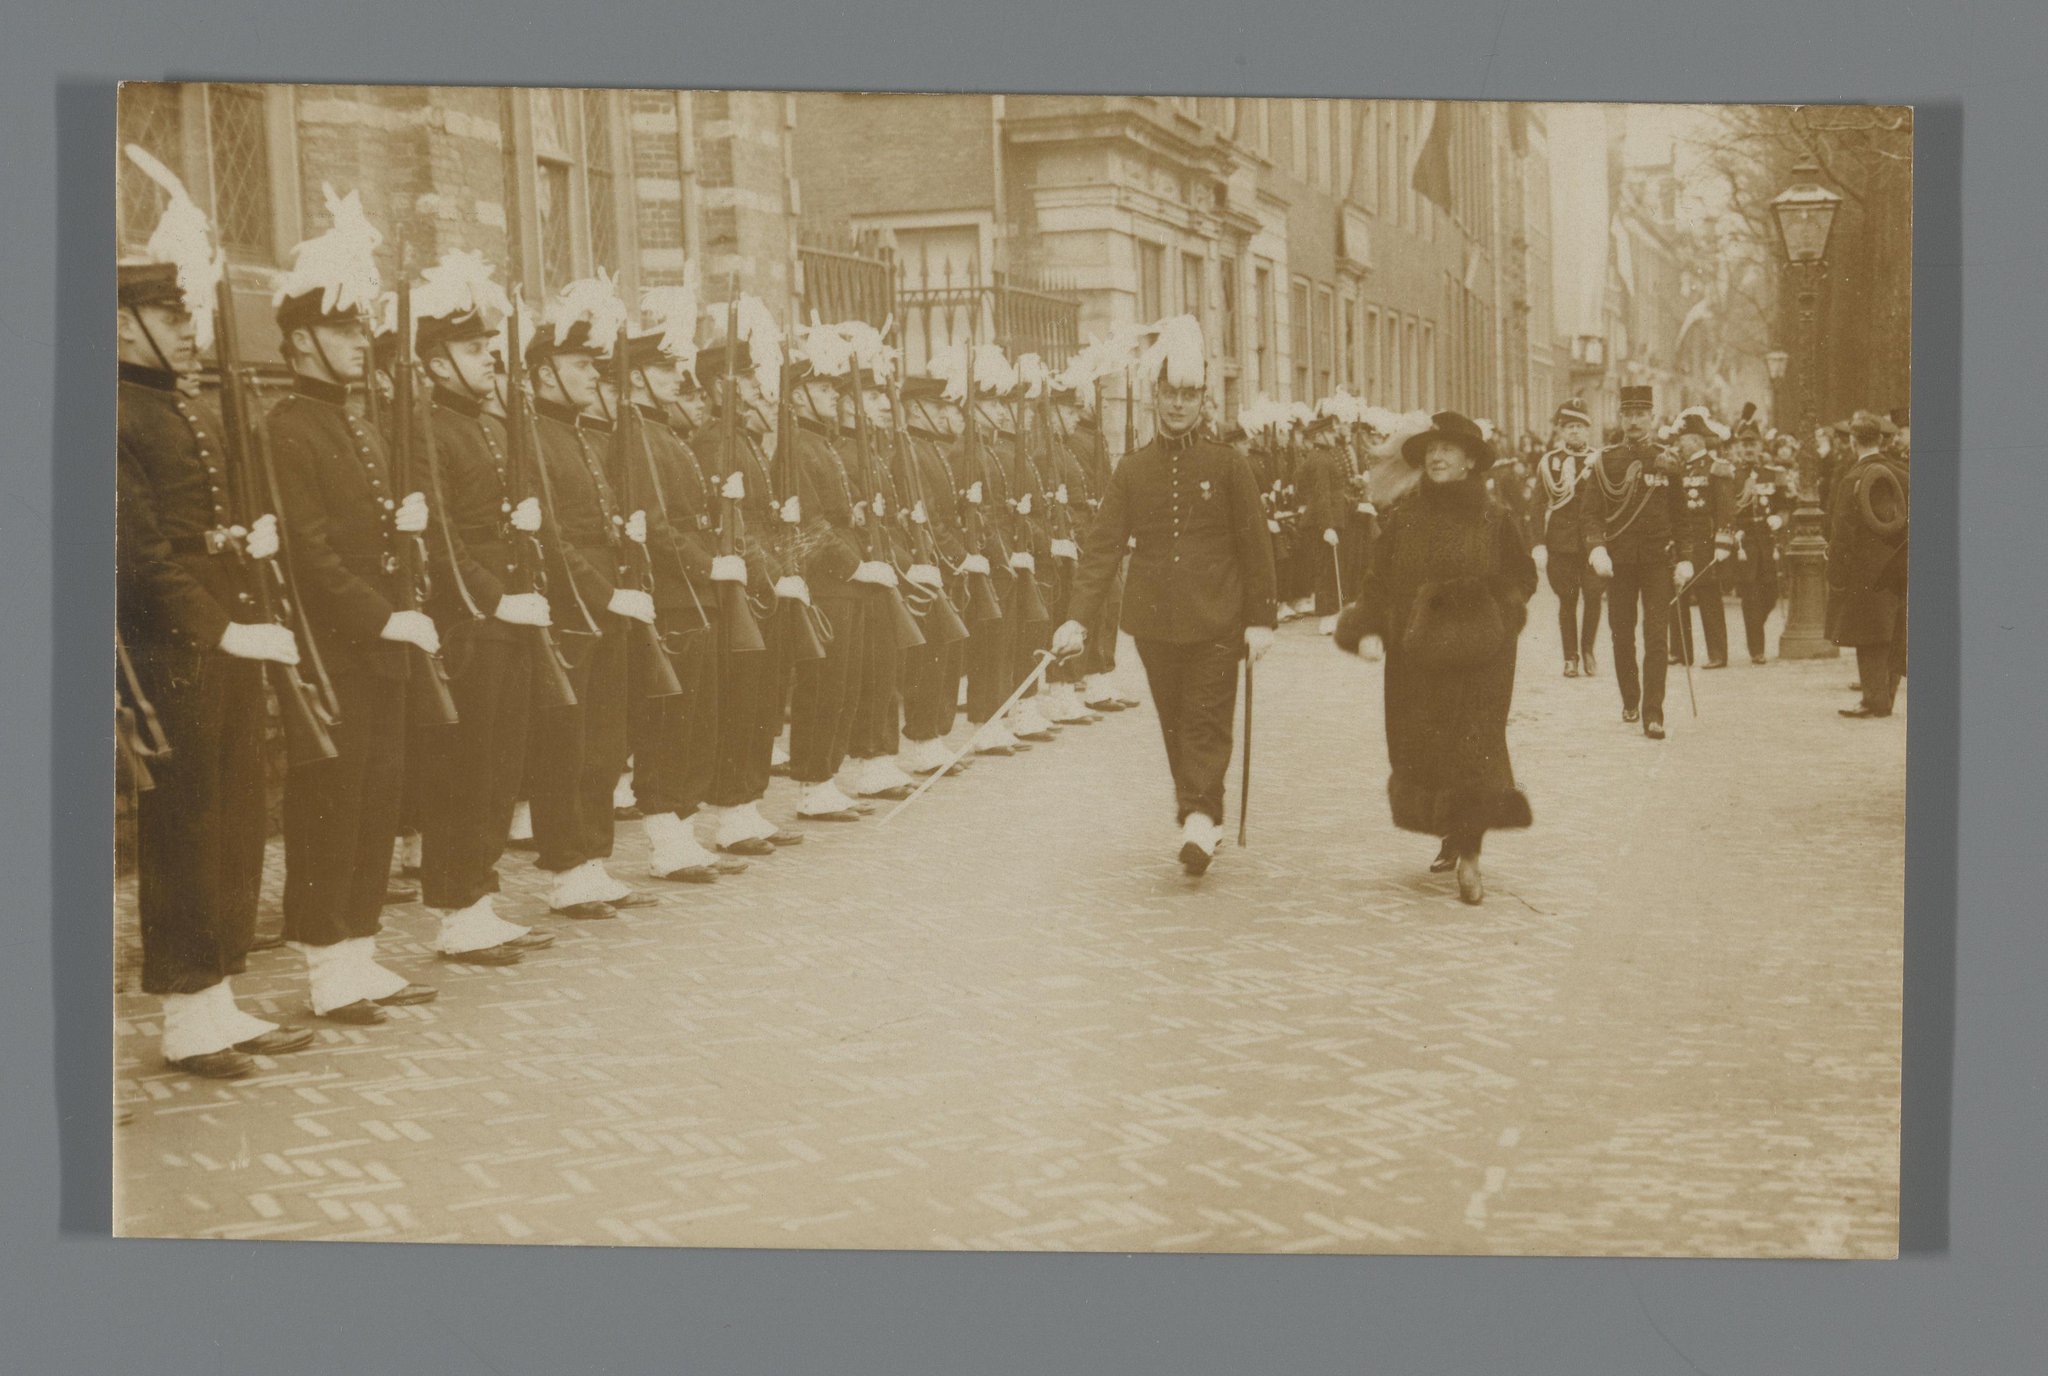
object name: ansichtkaart, prentbriefkaart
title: Koningin Wilhelmina inspecteert Pro Patria, voor het Academiegebouw in Leiden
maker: Anonymous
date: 1925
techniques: gelatin silver print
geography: leiden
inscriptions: stamp: ‘Vosmaer’, annotation: ‘1925 9 Febr. De optocht van Professoren. De Koningin inspecteert "Pro Patria"naast haar Zimmerman’